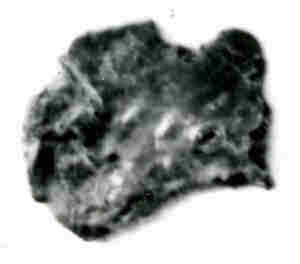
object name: coin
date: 718-814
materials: copper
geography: iran